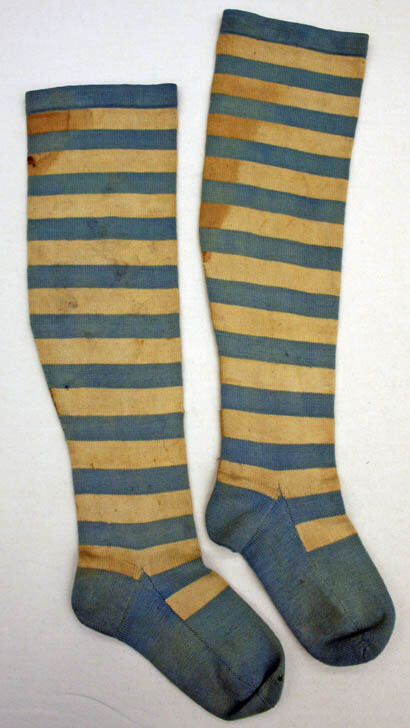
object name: stocking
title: Stockings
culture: american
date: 1850